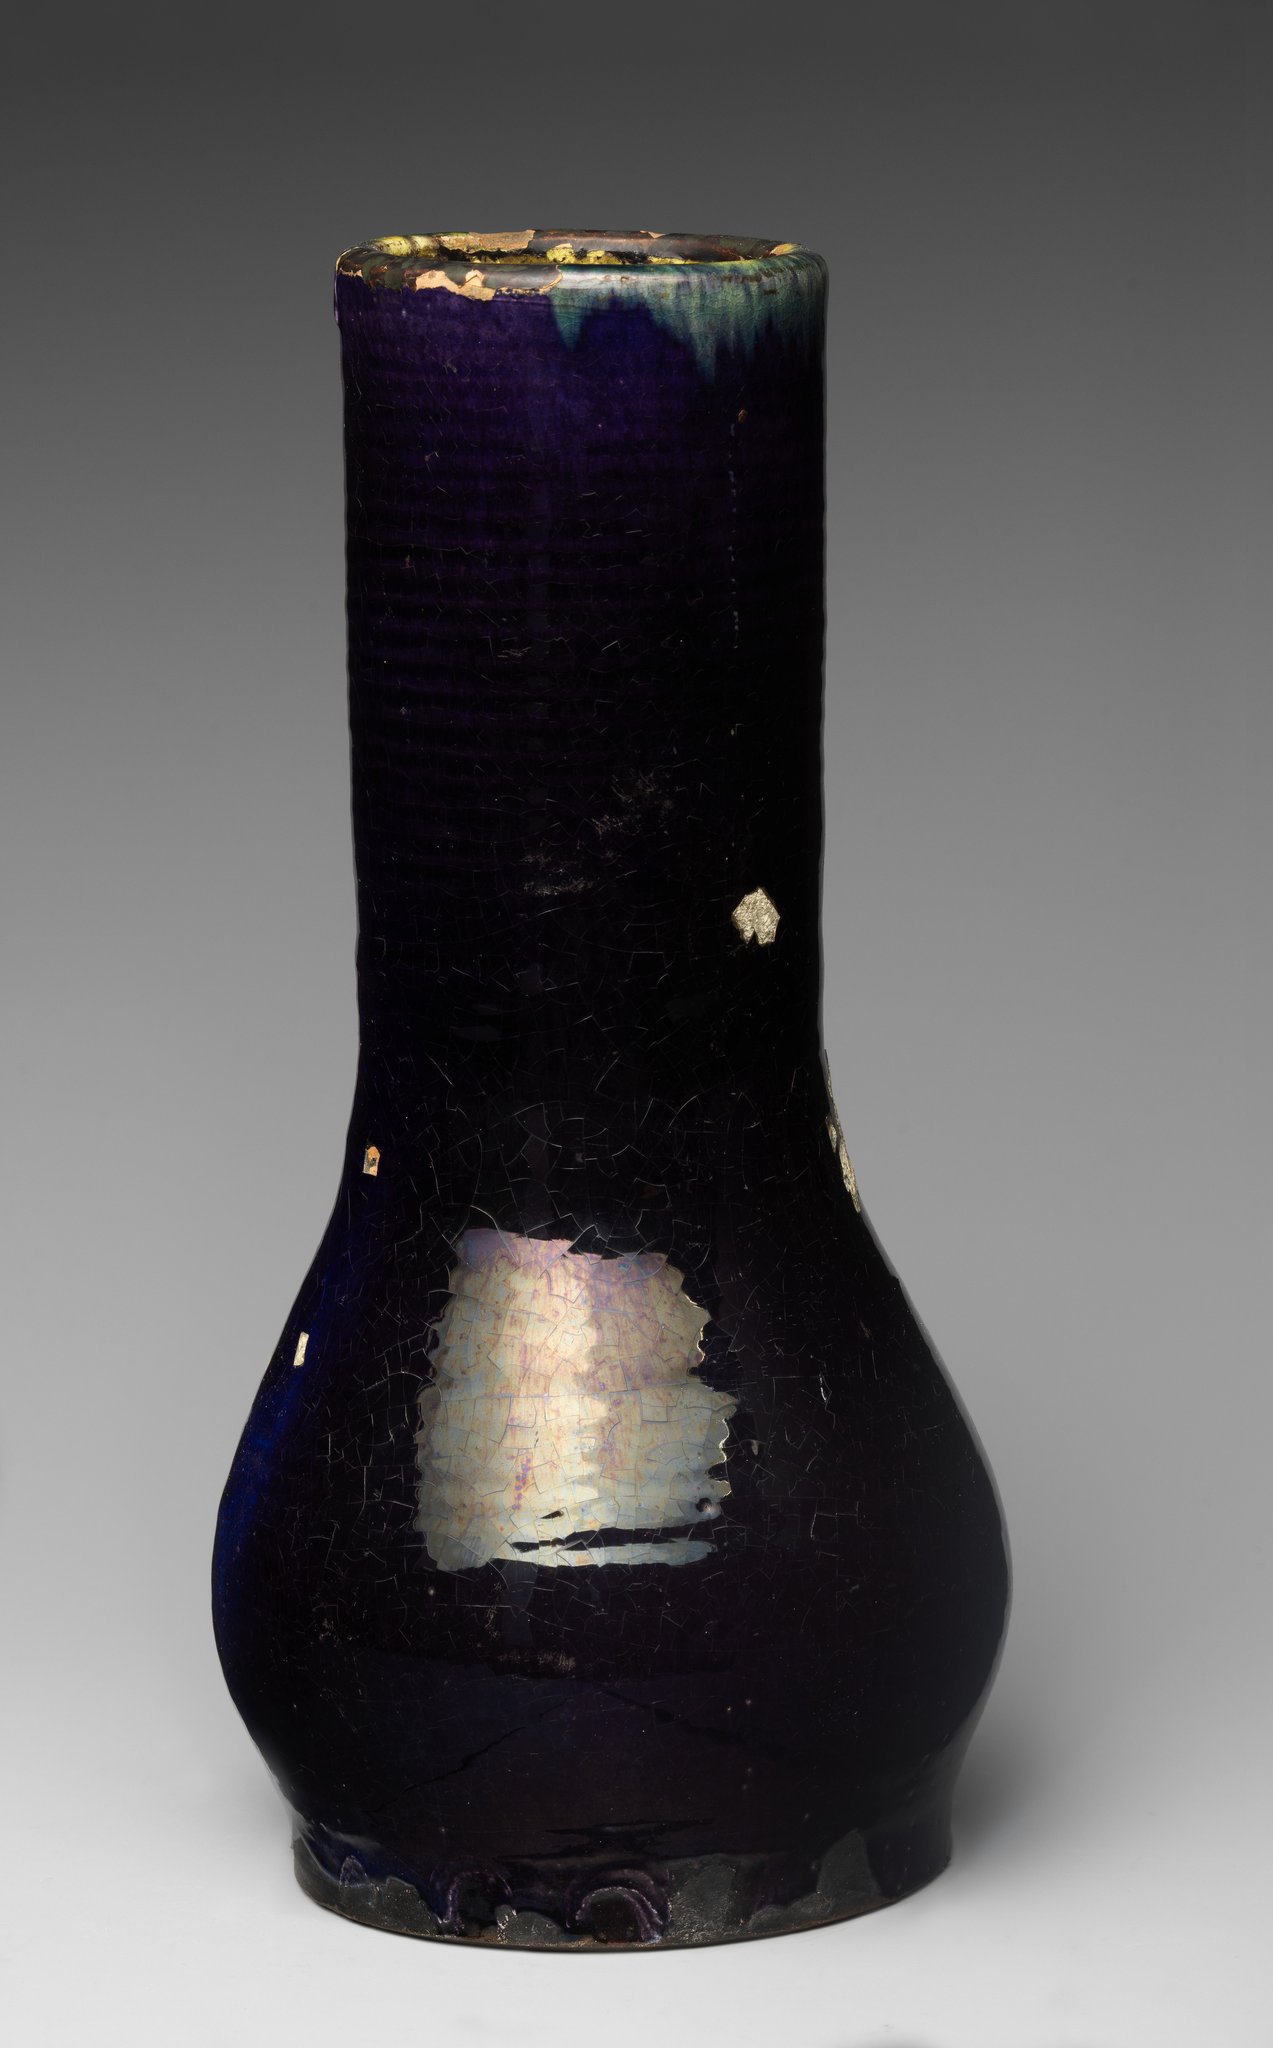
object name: vase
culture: japanese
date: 1801-1900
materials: clay, glaze